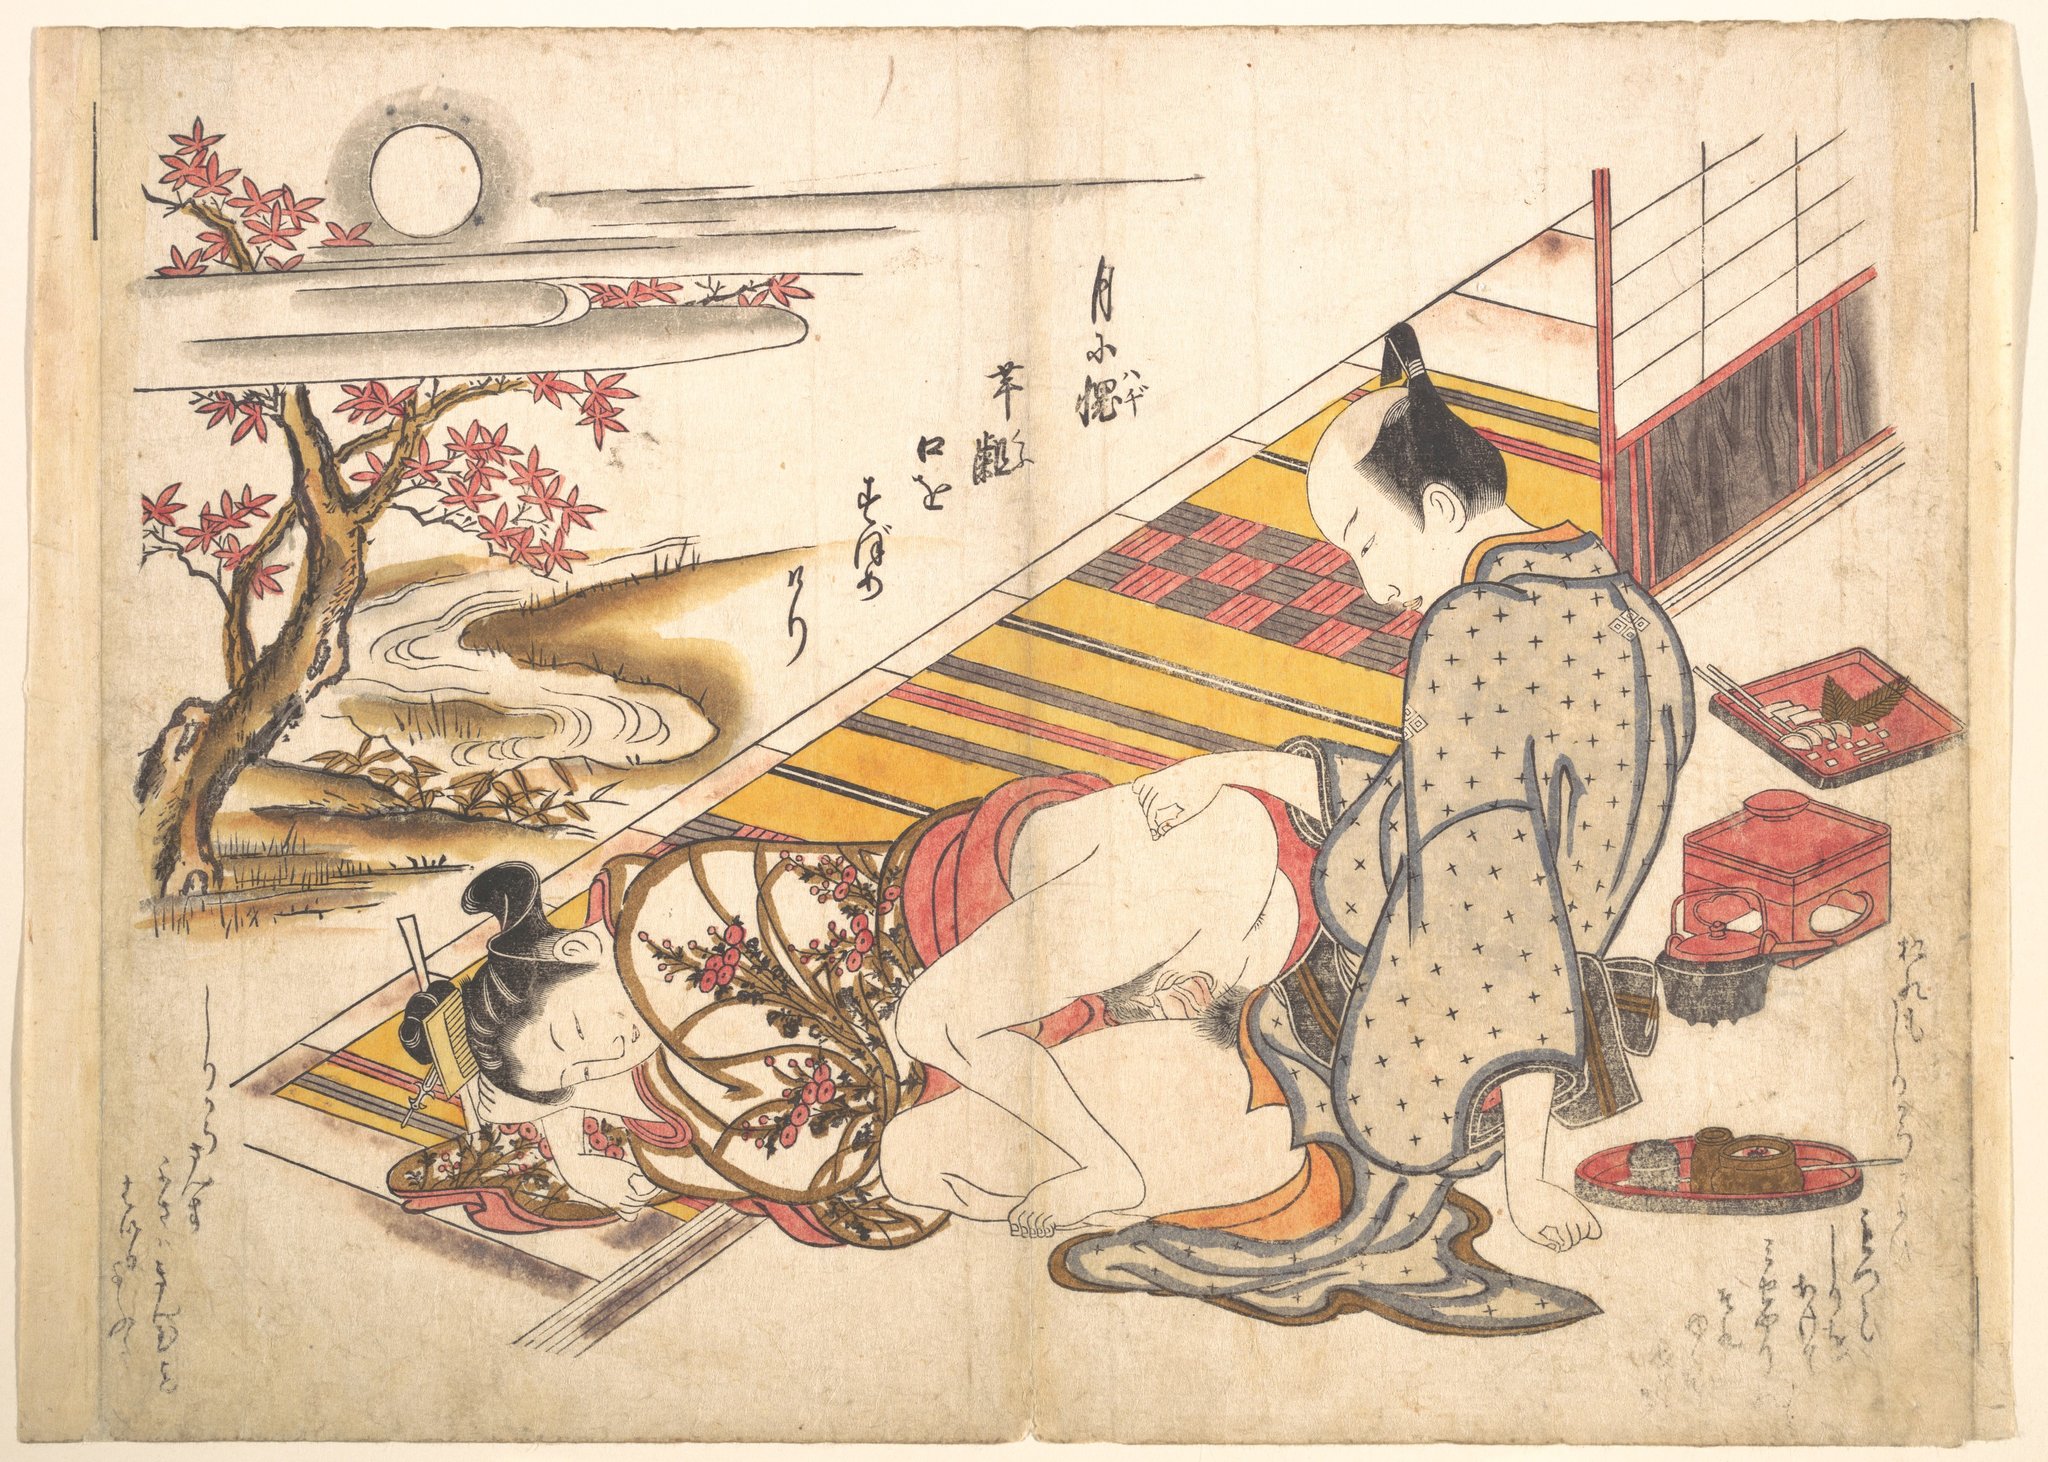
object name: print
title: Bedroom Scene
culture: japanese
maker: okumura masanobu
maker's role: artist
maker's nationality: japanese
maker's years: 1686-1764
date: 1739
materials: ink, paper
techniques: hand coloring, woodblock print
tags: bedrooms,couples,men,women